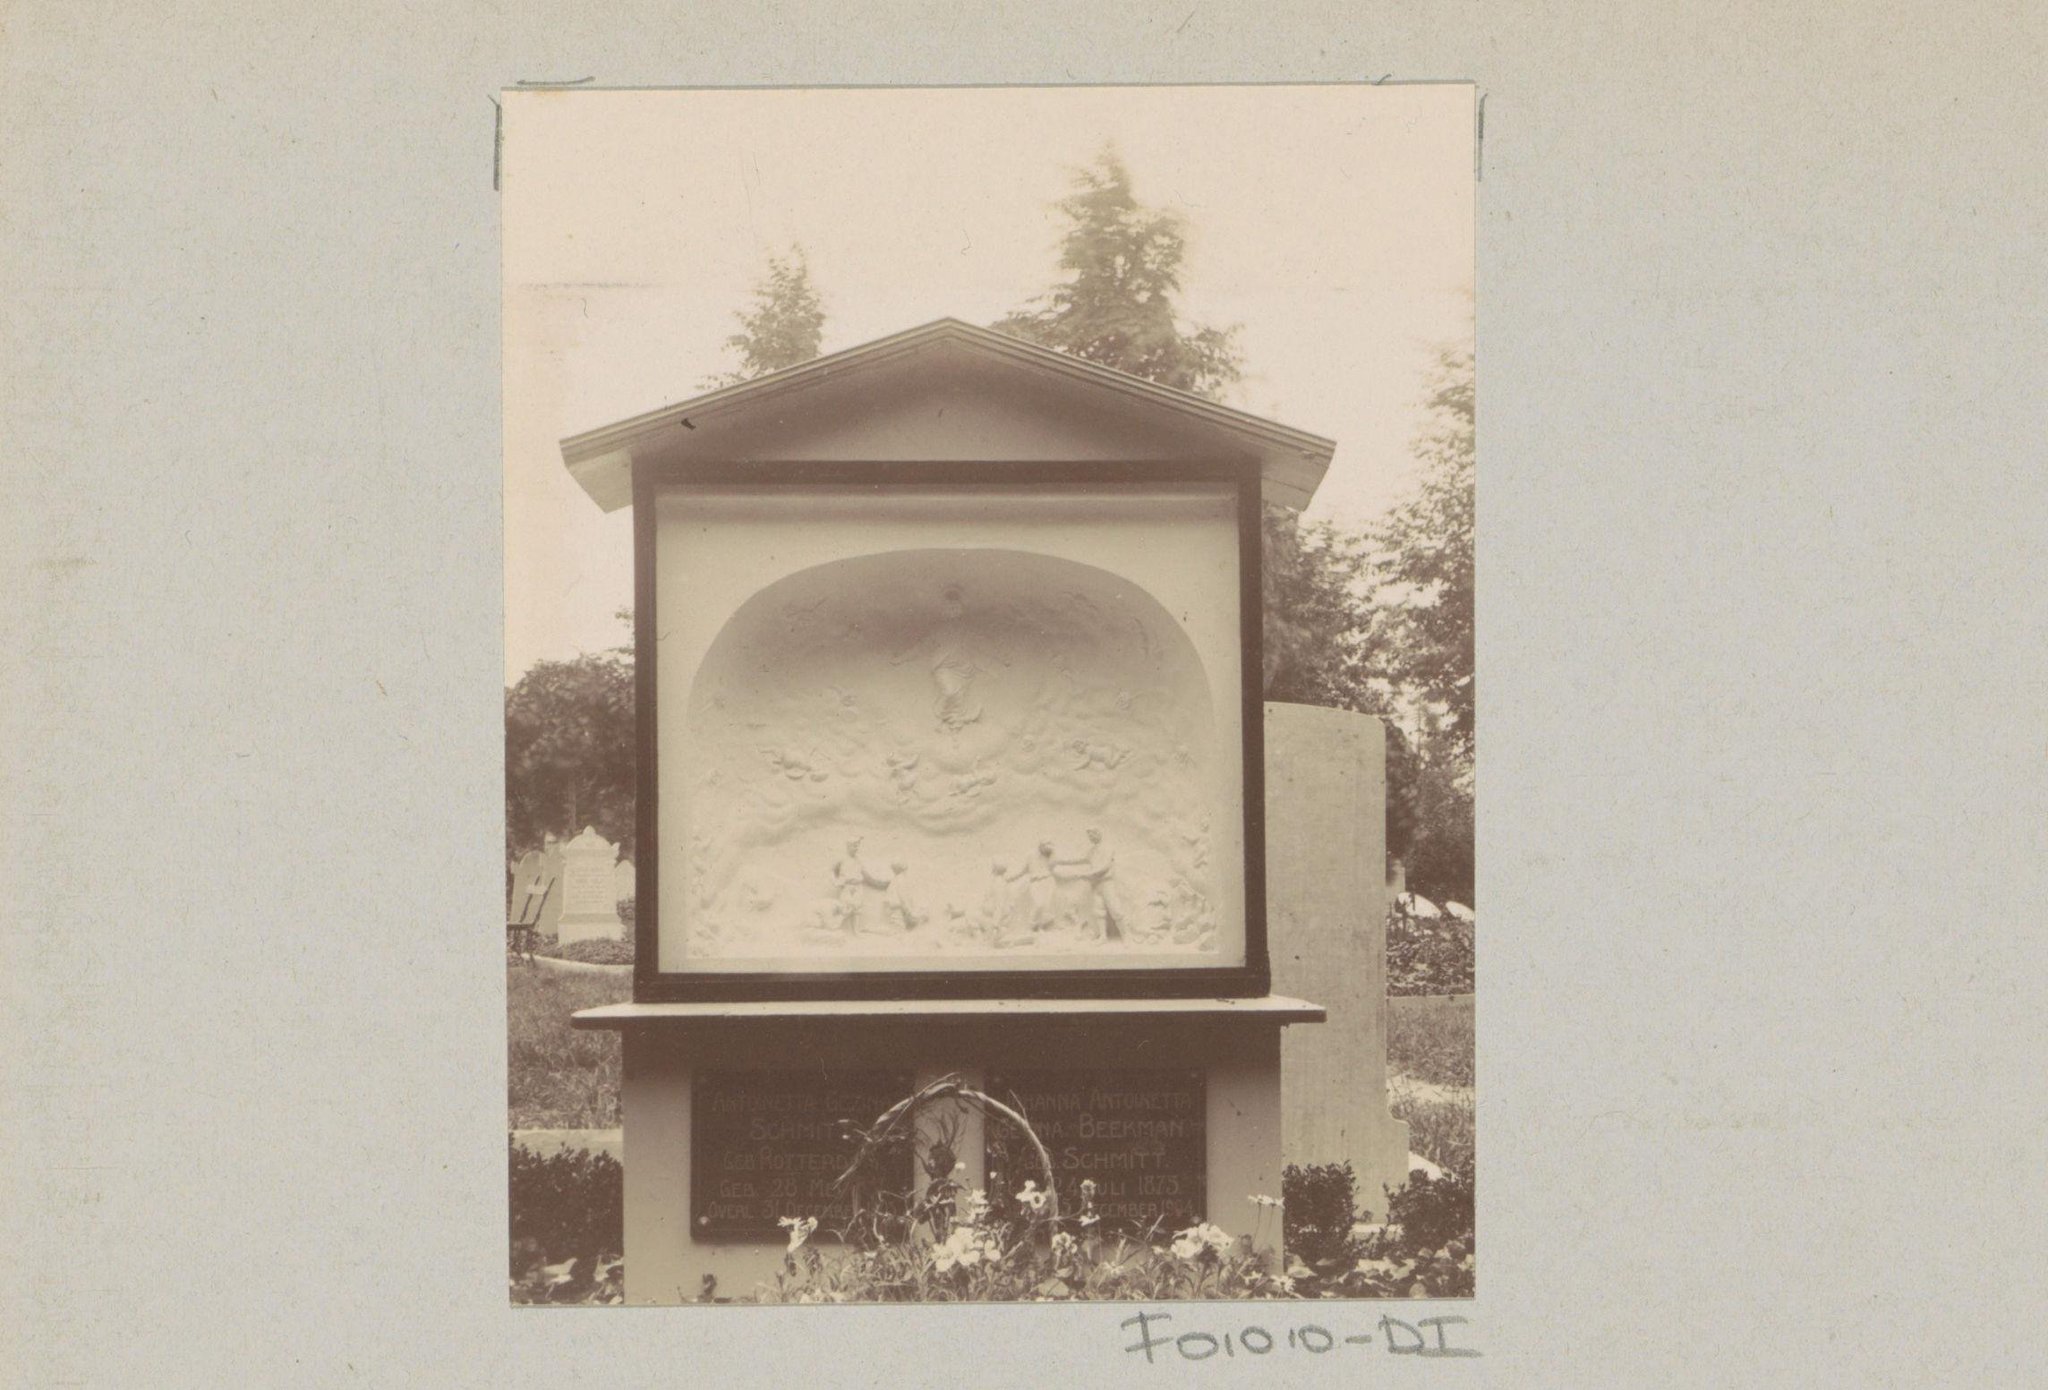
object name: photograph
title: Monument op een begraafplaats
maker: Anonymous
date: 1904-1910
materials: photographic support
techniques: daylight paper print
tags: grave, tomb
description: Op de voet van het monument zijn zichtbaar de namen Beekman en Smitt. Onderdeel van Familiealbum met onder meer foto's van Wijnhandel Kraaij & Co. Bordeaux-Amsterdam.